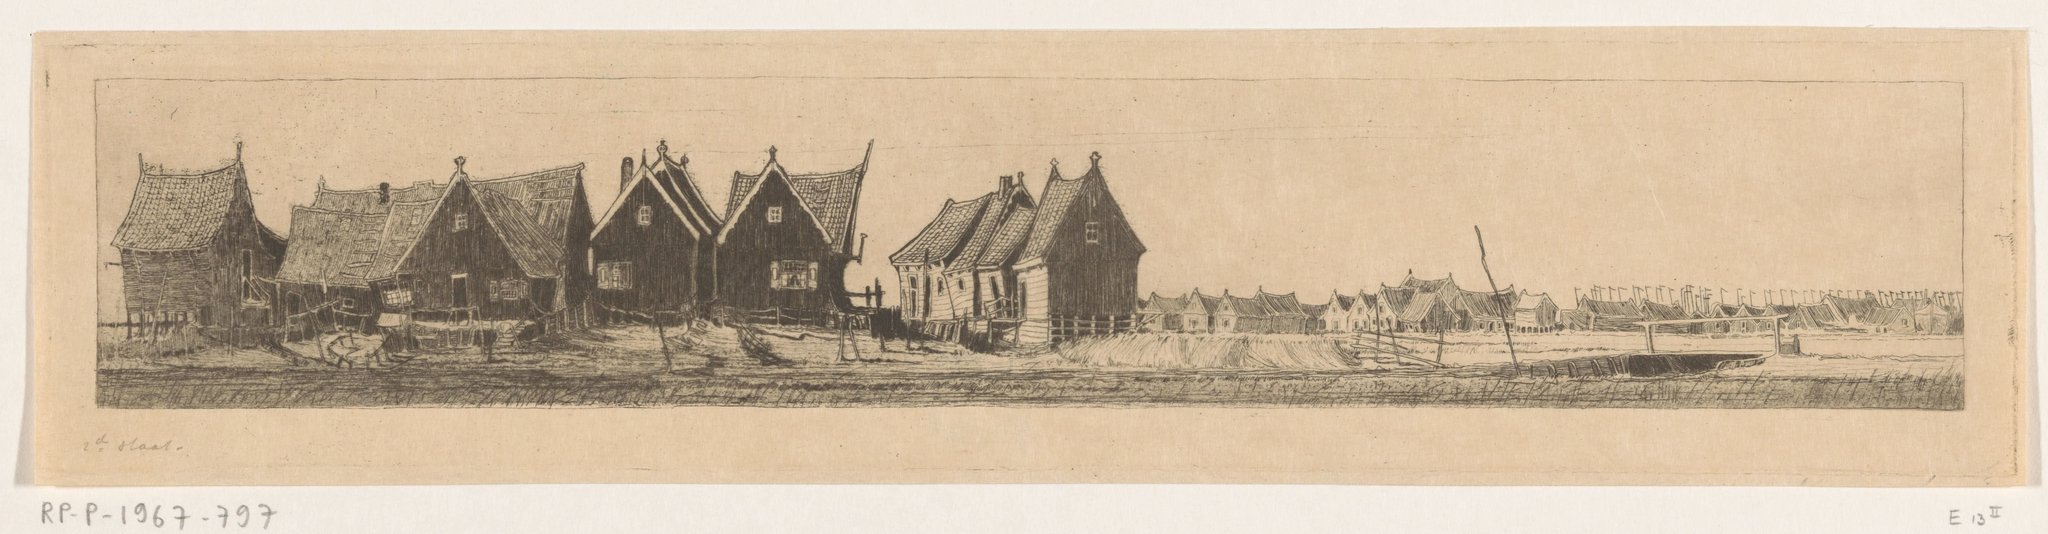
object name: print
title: Zicht op het eiland Marken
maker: wijnand otto jan nieuwenkamp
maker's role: draughtsman, print maker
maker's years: 1874-1950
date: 1896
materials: paper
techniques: etching, intaglio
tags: village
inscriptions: collector's mark: Lugt 2228, collector's mark: Lugt 2760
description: De Wittewerf op het eiland Marken. Op de achtergrond de Havenbuurt.